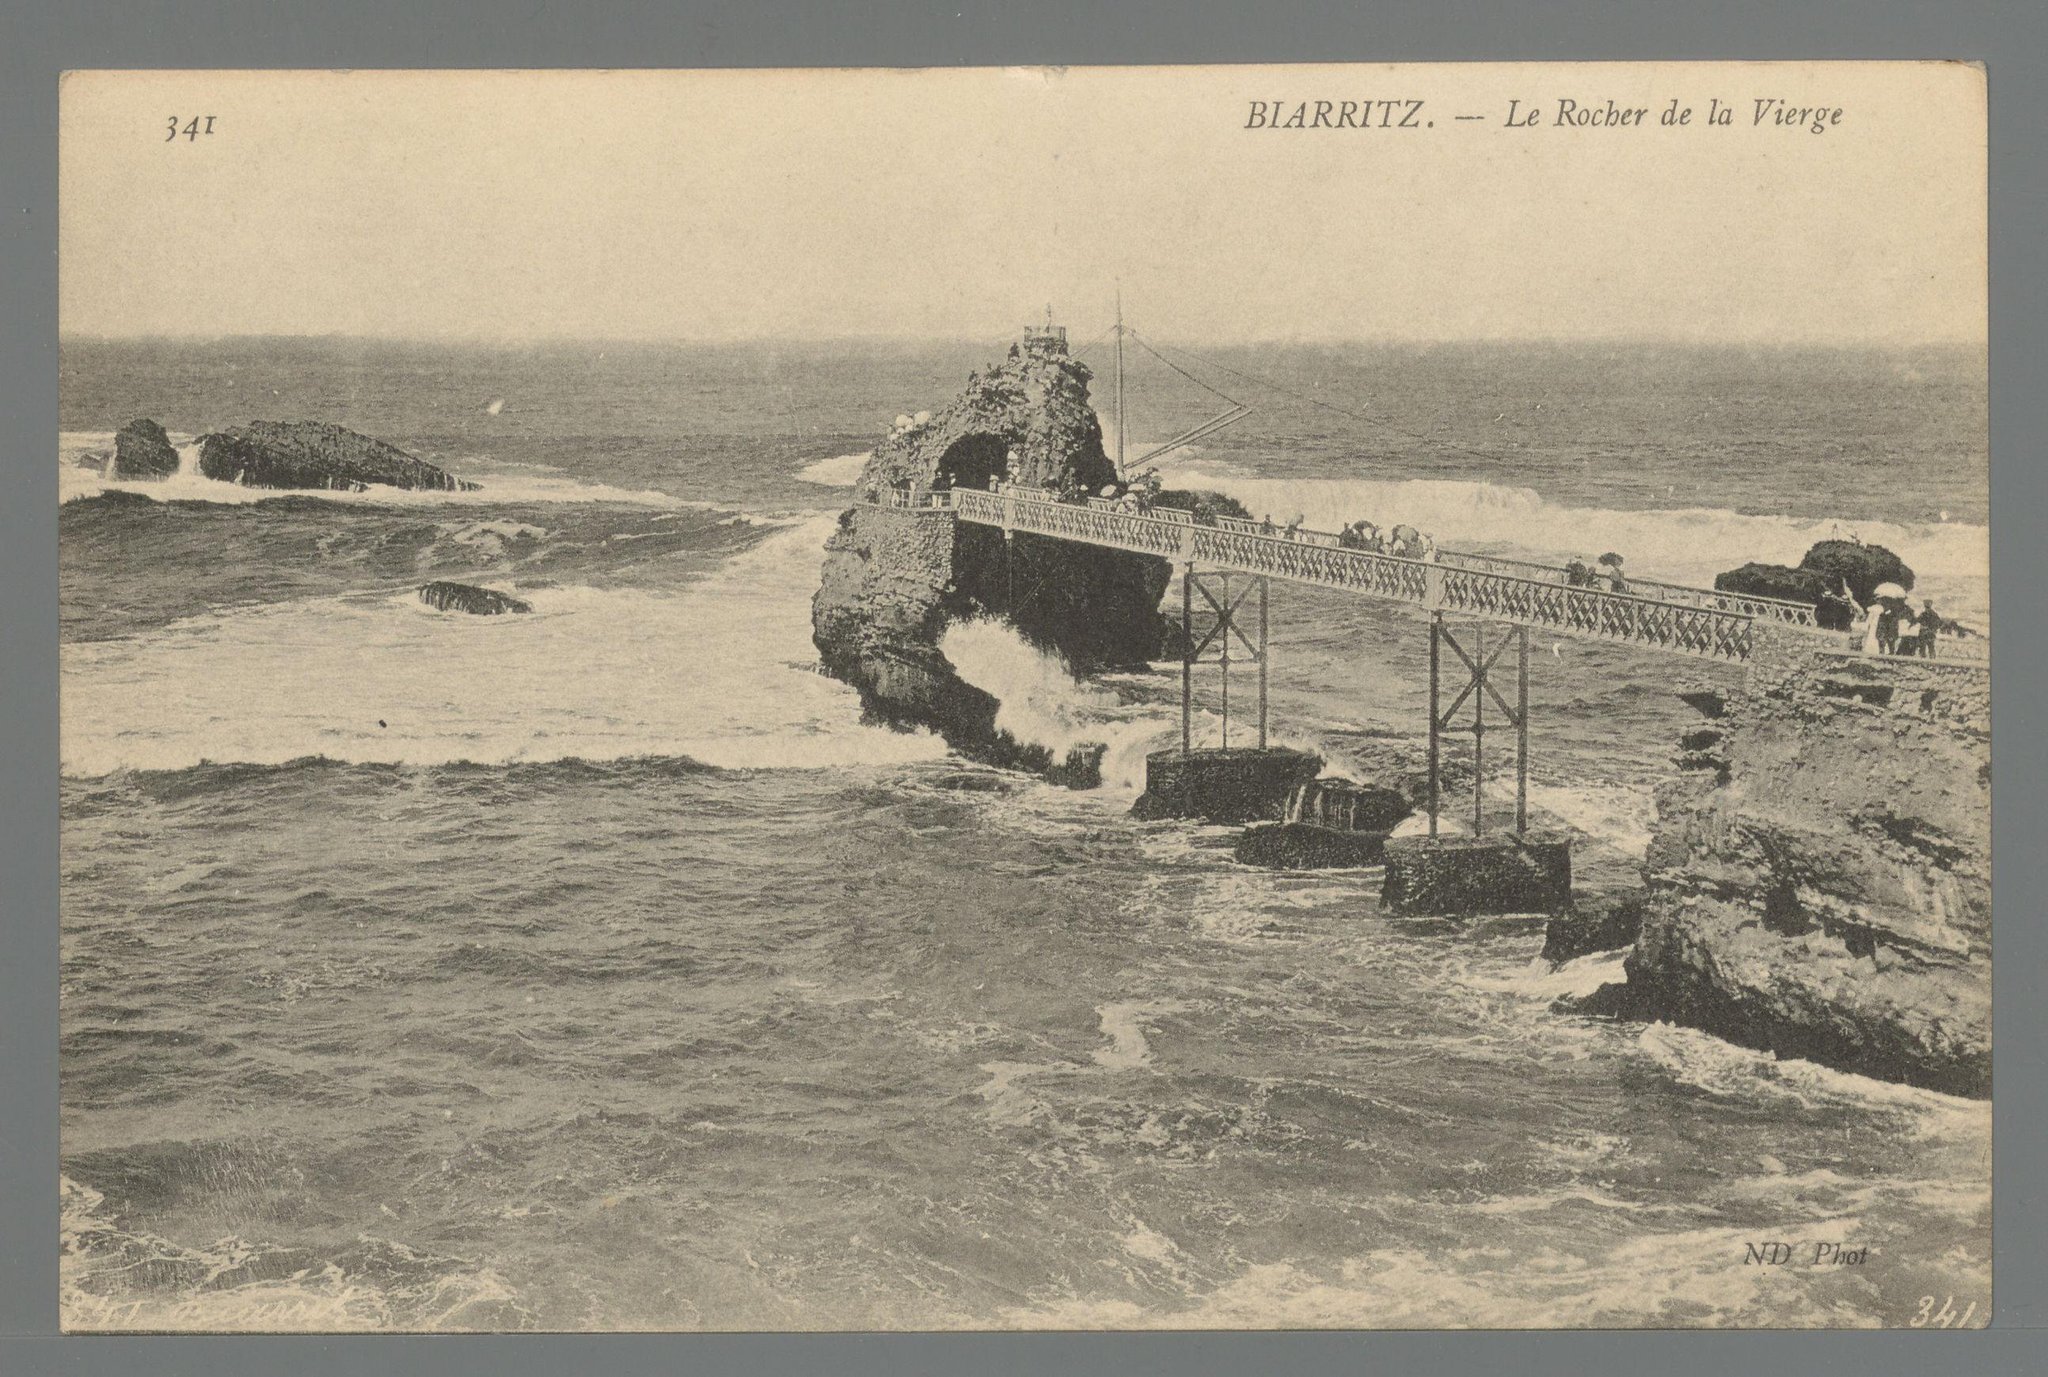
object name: ansichtkaart, prentbriefkaart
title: Biarritz. Le Rocher de la Vierge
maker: Anonymous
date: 1903-1918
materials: cardboard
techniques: photograph, writing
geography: paris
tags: rock-formations, bridge, sea (seascape) (+ landscape with figures, staffage)